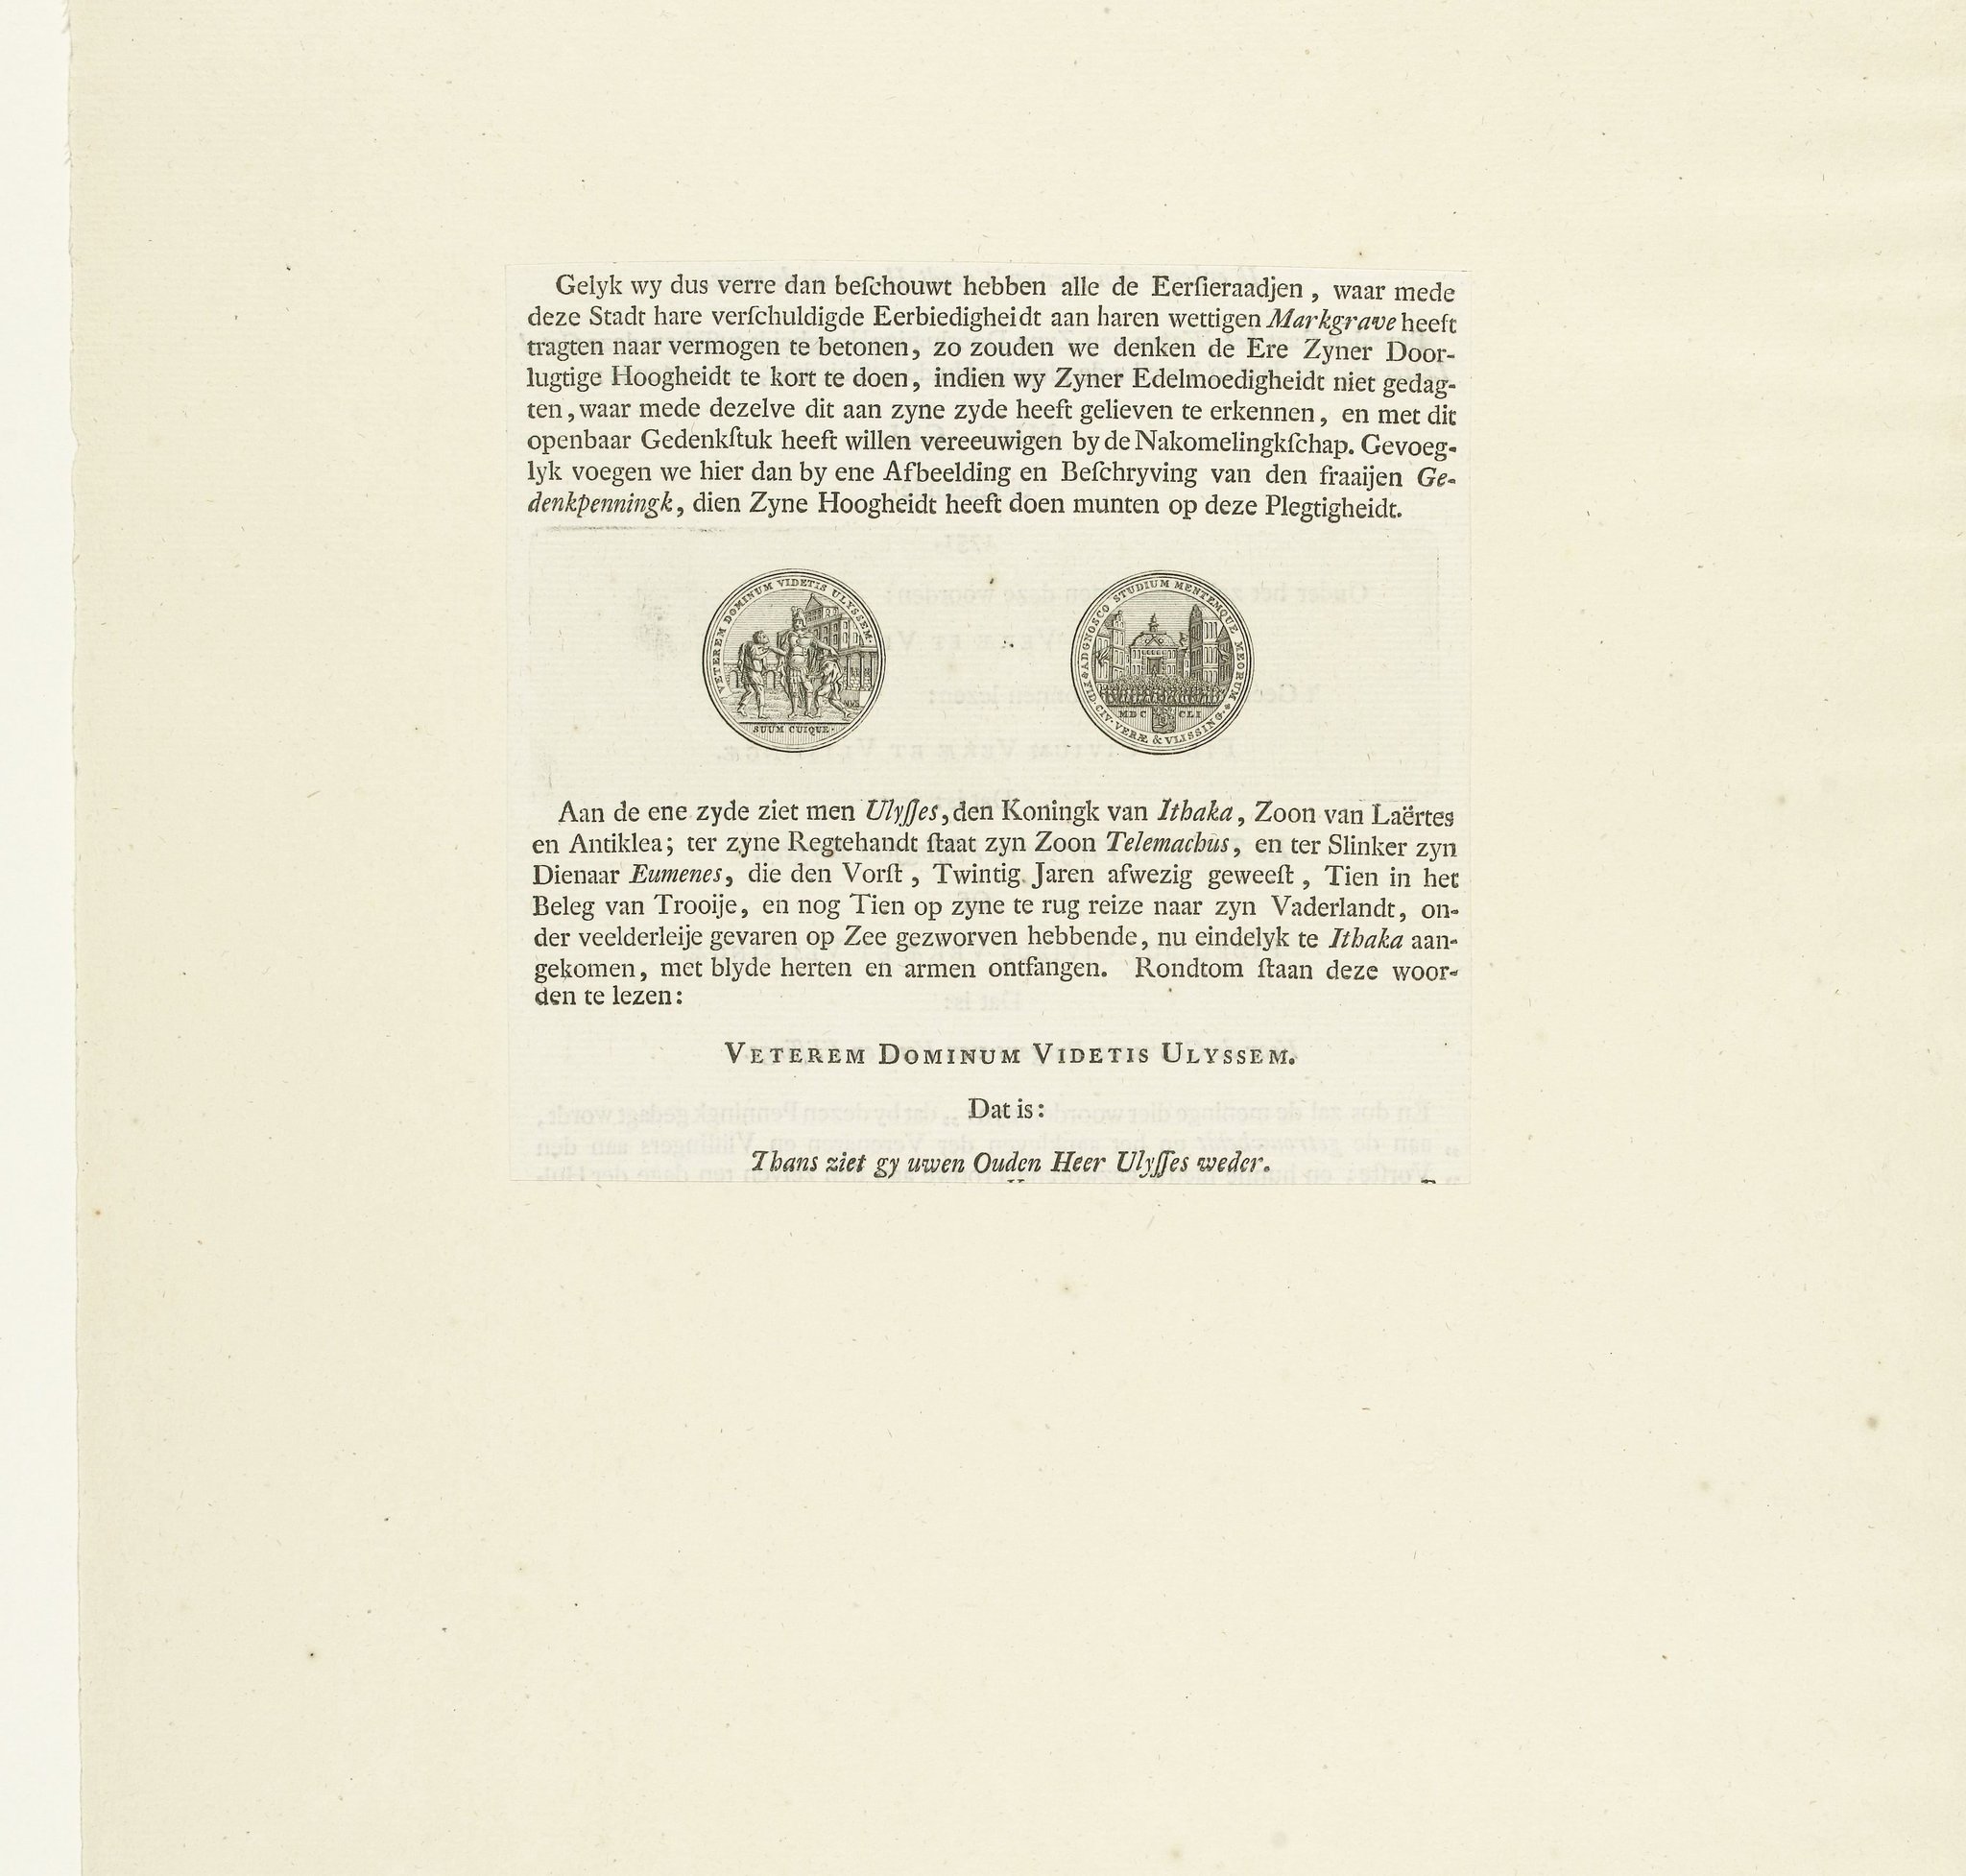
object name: penningverklaring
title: Strooippenning op de inhuldiging van stadhouder Willem IV als markgraaf van Veere op 1 juni 1751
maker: caspar jacobsz. philips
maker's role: draughtsman, print maker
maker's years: 1732-1789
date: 1751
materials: paper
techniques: etching, letterpress printing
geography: northern netherlands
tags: willem iv (prins van oranje-nassau), medal (considered as a piece of sculpture, regardless of its specific function)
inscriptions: collector's mark: Lugt 2228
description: Uitgeknipt blad met de strooipenning of gedenkpenning op de inhuldiging van stadhouder Willem IV als markgraaf van Veere op 1 juni 1751. Onderdeel van de illustraties van de feestelijke inhuldiging van stadhouder Willem IV als markgraaf van Veere op 1 juni 1751. Tekst met plaat van voor- en keerzijde van de penning.